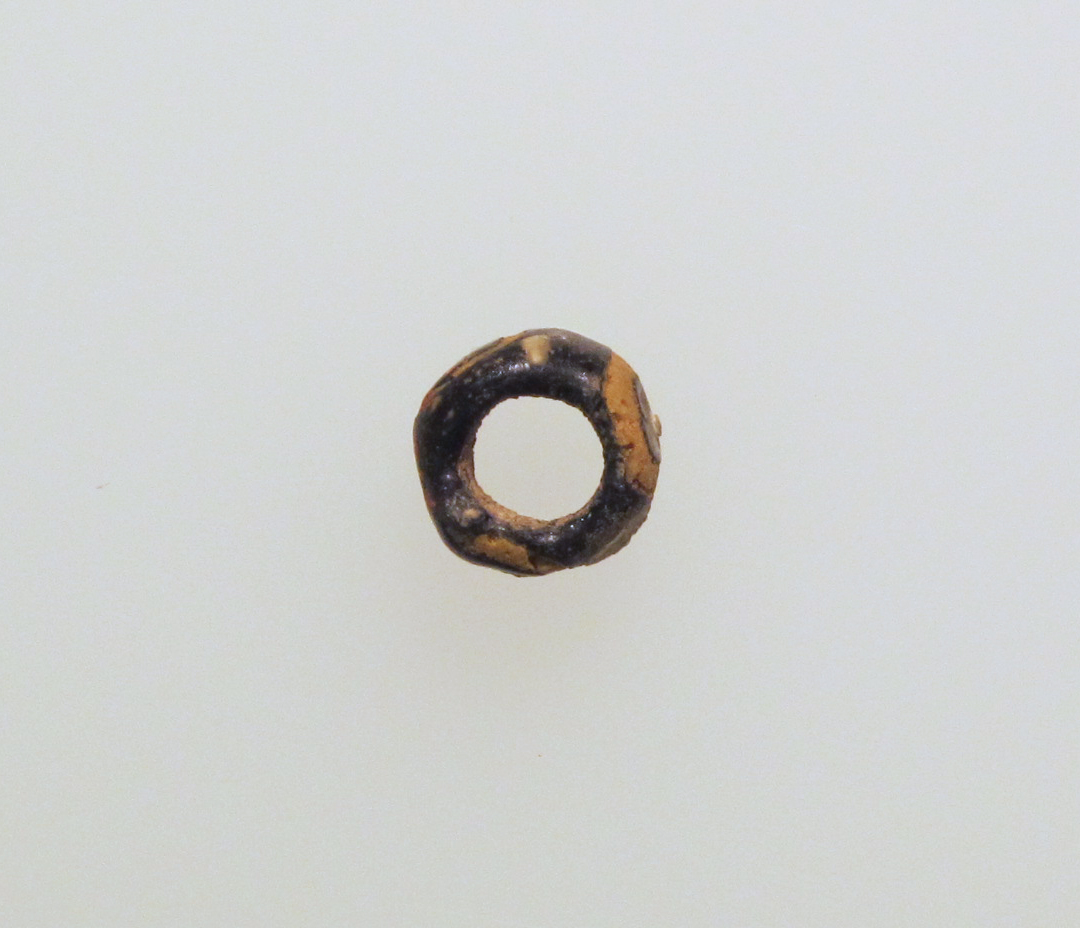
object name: bead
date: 7000 BCE-330 CE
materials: glass